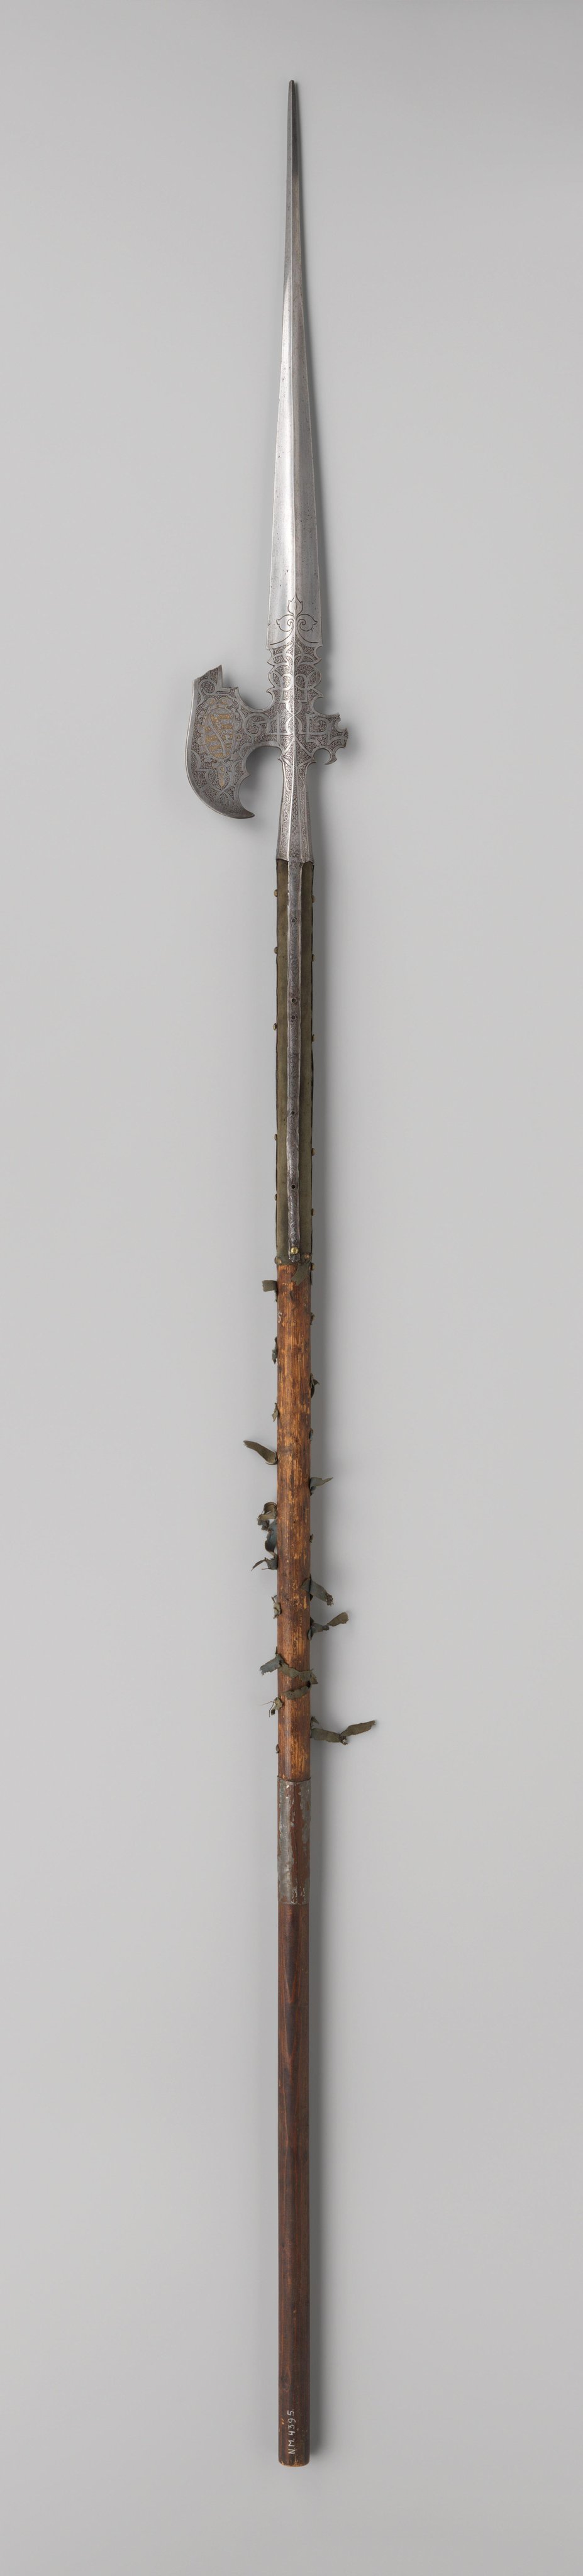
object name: halberd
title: Hellebaard, gegraveerd, de stok met blauwe stof omwonden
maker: Anonymous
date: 1540-1550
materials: iron, textile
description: Hellebaard, gegraveerd, de stok met blauwe stof omwonden. Gegraveerde vier lippen. Getekende merken. De stok afgebroken, twee punten ontbreken.